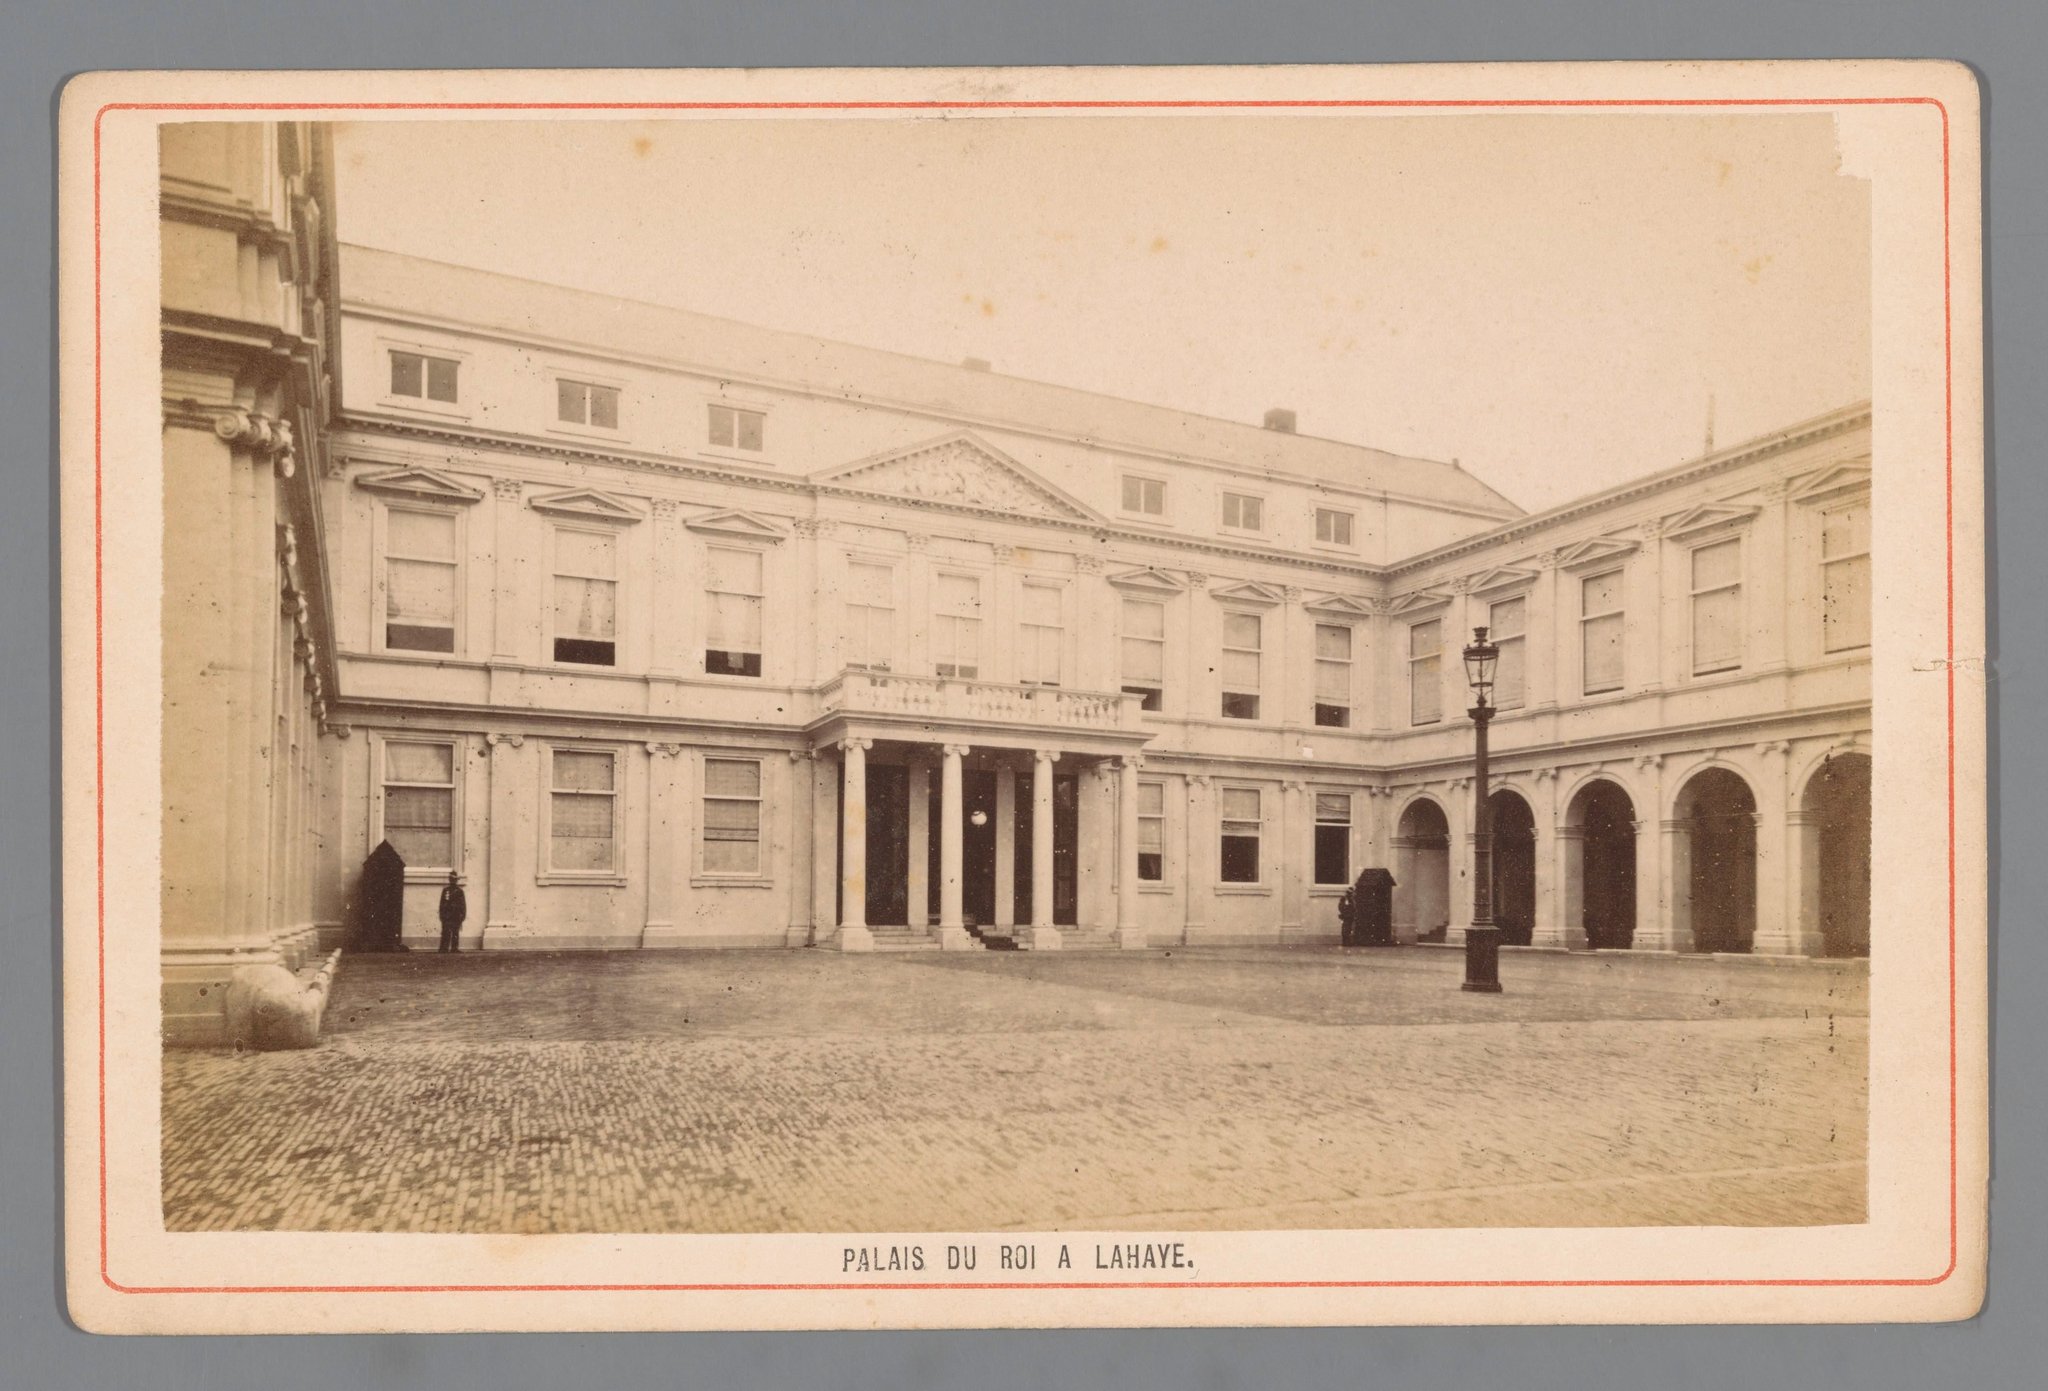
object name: photograph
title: Palais du roi a Lahaye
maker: Anonymous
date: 1880-1900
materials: cardboard, photographic support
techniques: albumen print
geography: the hague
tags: palace, façade (of house or building)